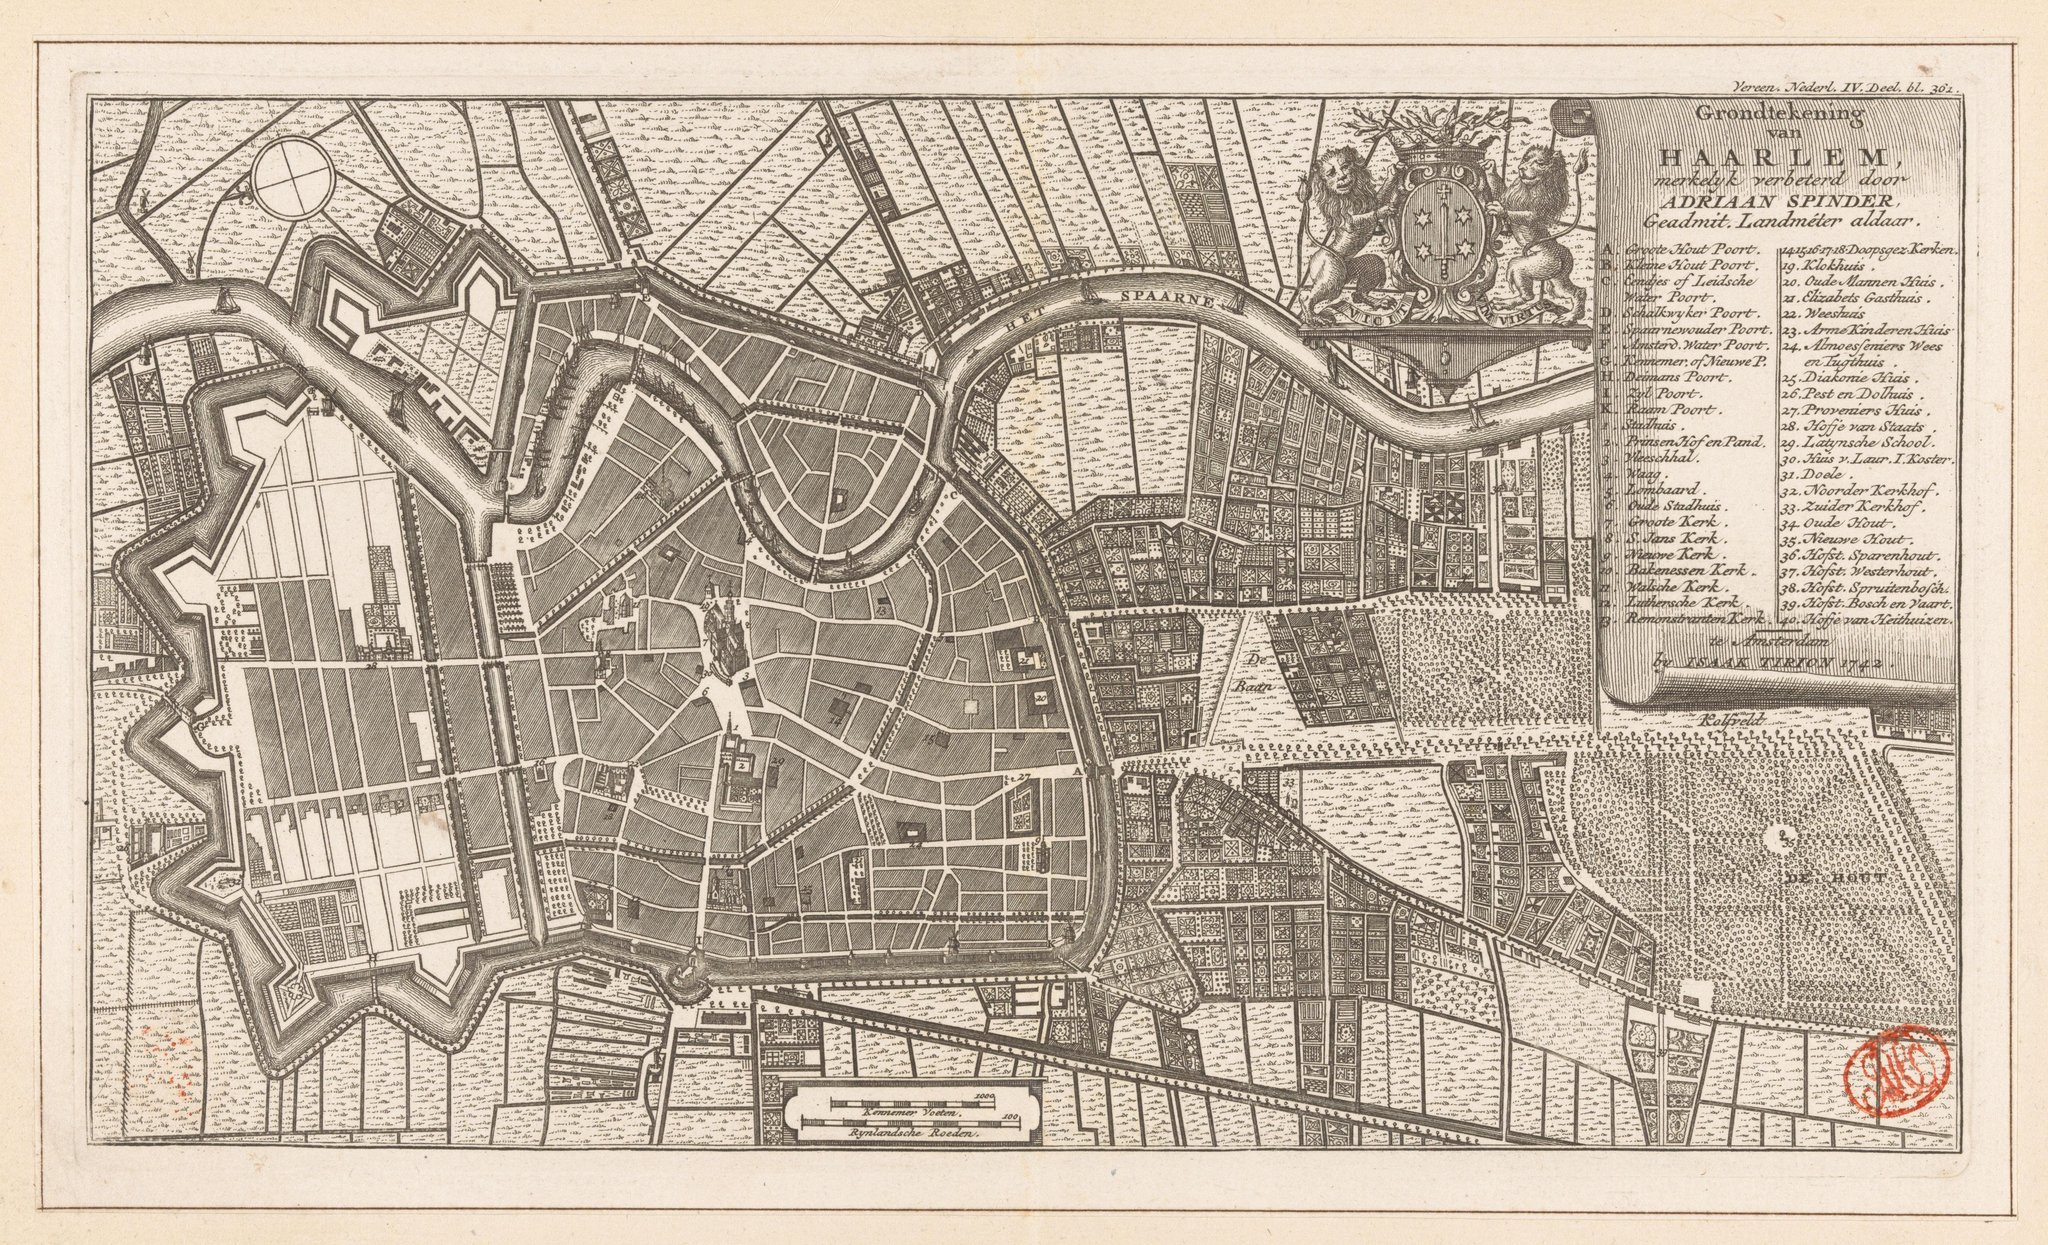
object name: print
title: Plattegrond van Haarlem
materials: paper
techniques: engraving, etching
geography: amsterdam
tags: coat of arms (as symbol of the state, etc.) (+ city; municipal), maps of cities, haarlem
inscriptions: collector's mark: Lugt 195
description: Plattegrond in vogelvluchtperspectief. Onderaan links van het midden twee schaalstokken: 1000 Kennemer voeten; 100 Rynlandsche roeden. Rechtsboven het wapen van Haarlem met daarnaast een cartouche met de titel en een legenda A-K en 1-40. Rechtsboven gemerkt: Vereen. Nederl. IV. Deel. bl. 362.